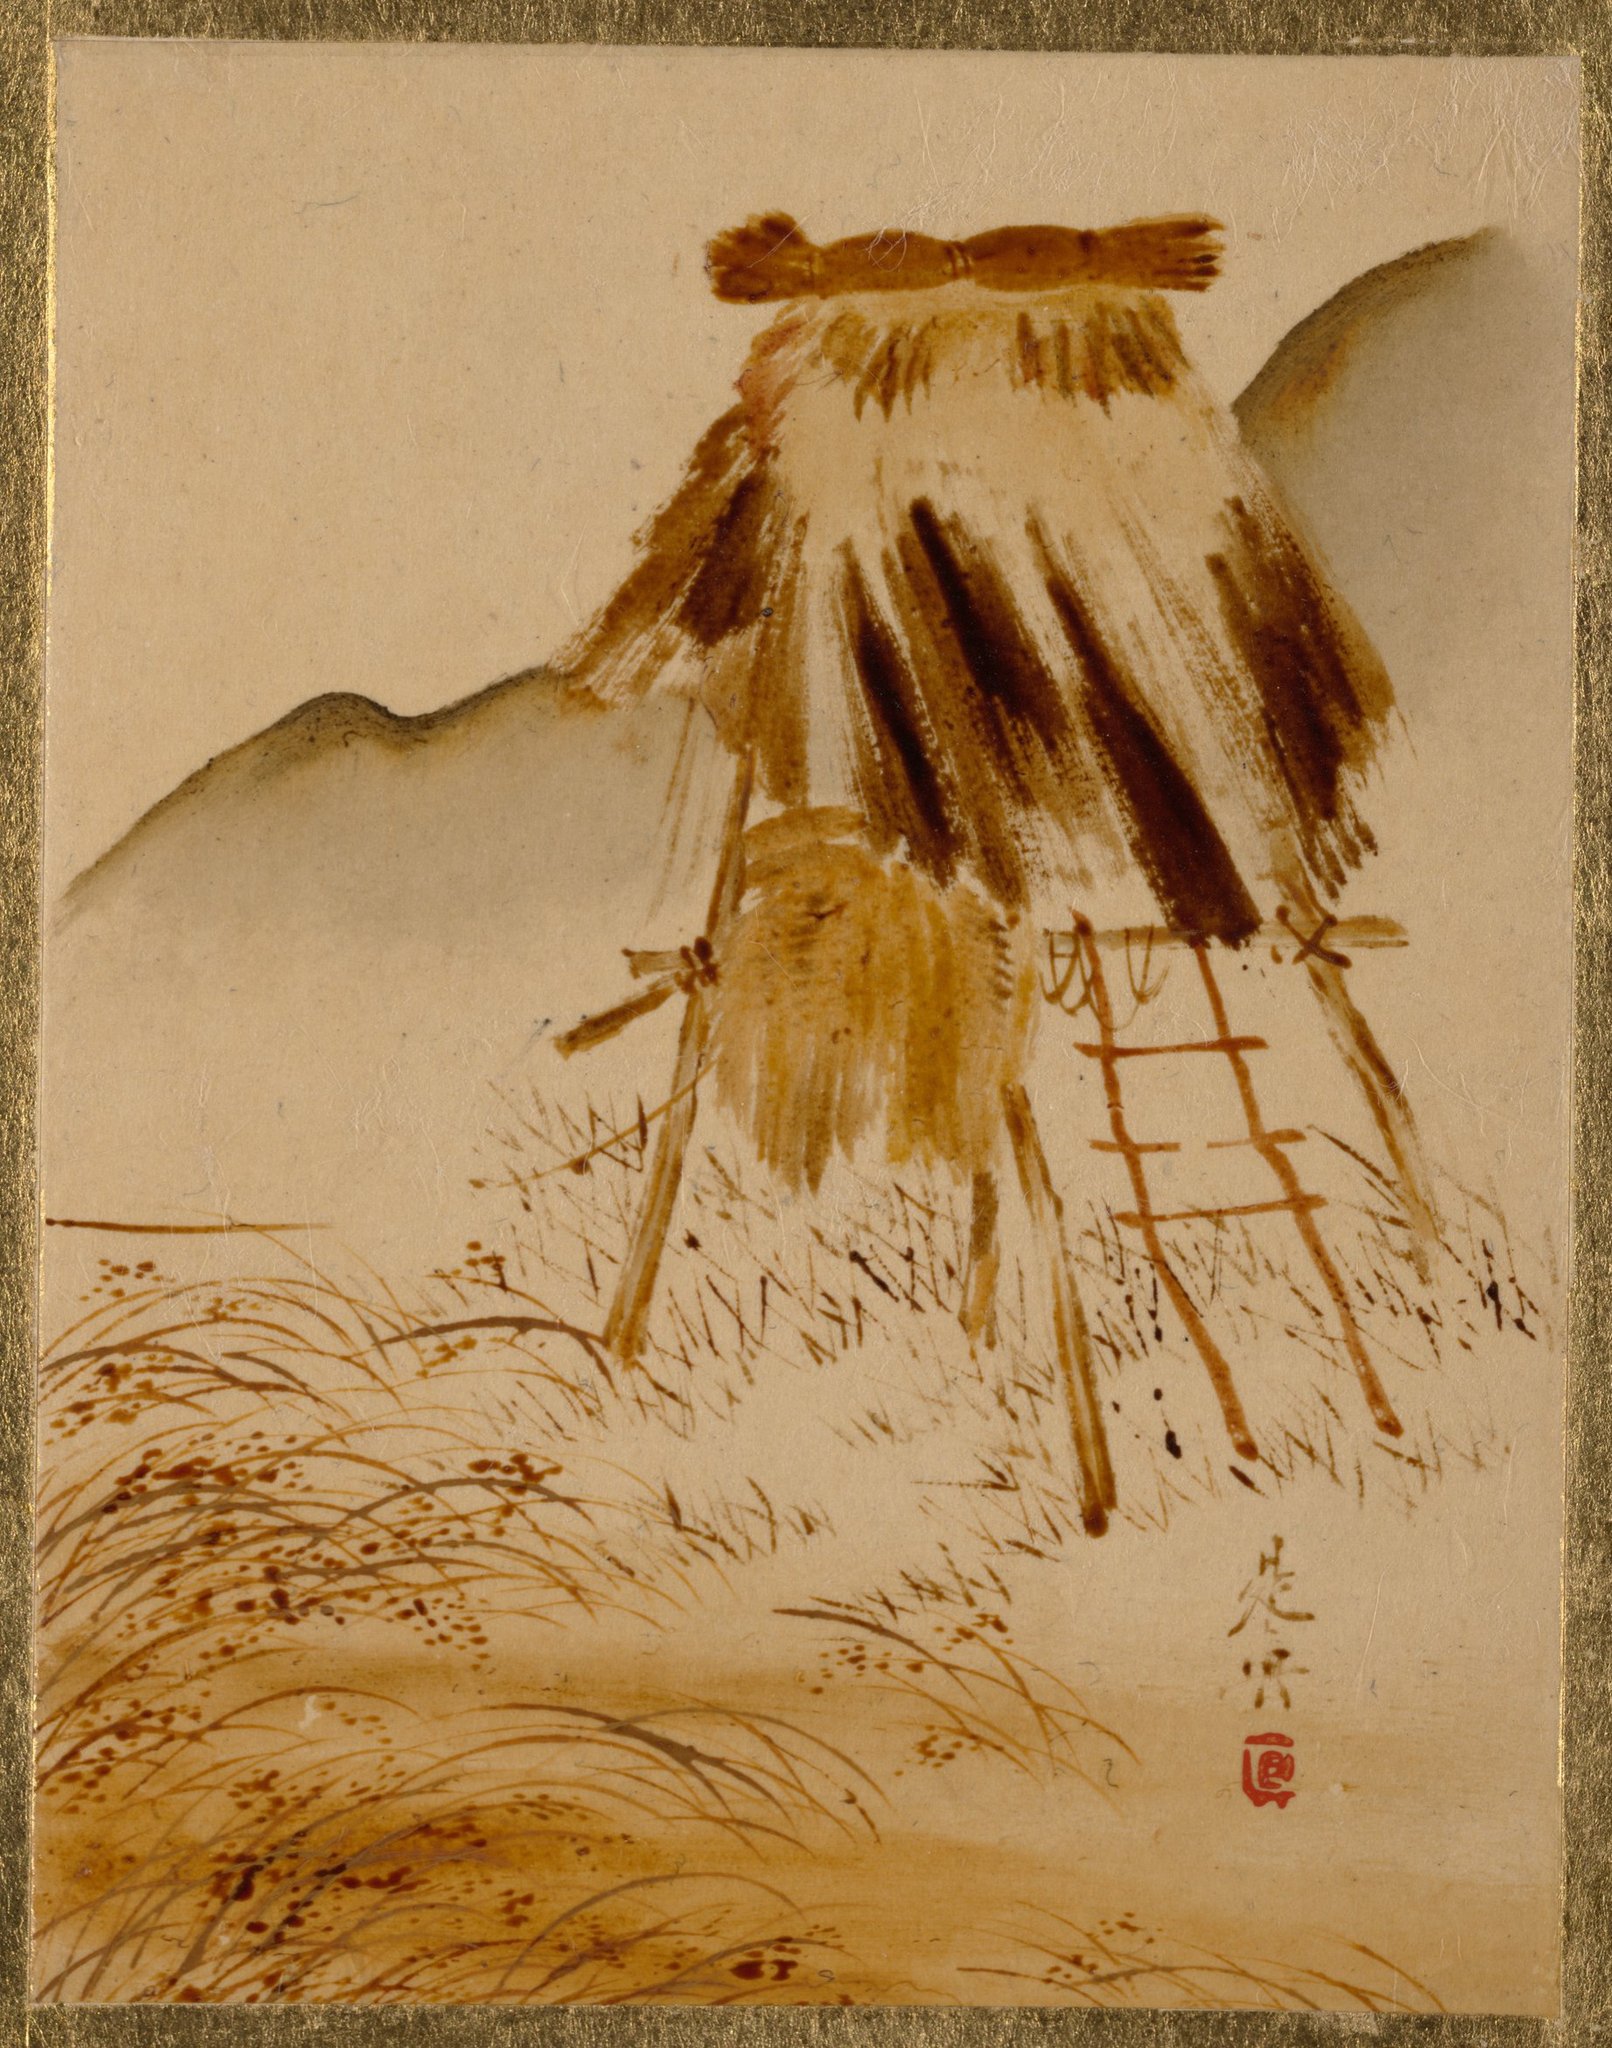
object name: album leaf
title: Rice-Drying Frame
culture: japanese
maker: shibata zeshin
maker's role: artist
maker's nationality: japanese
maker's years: 1807-1891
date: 1807-1868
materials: lacquer, paper